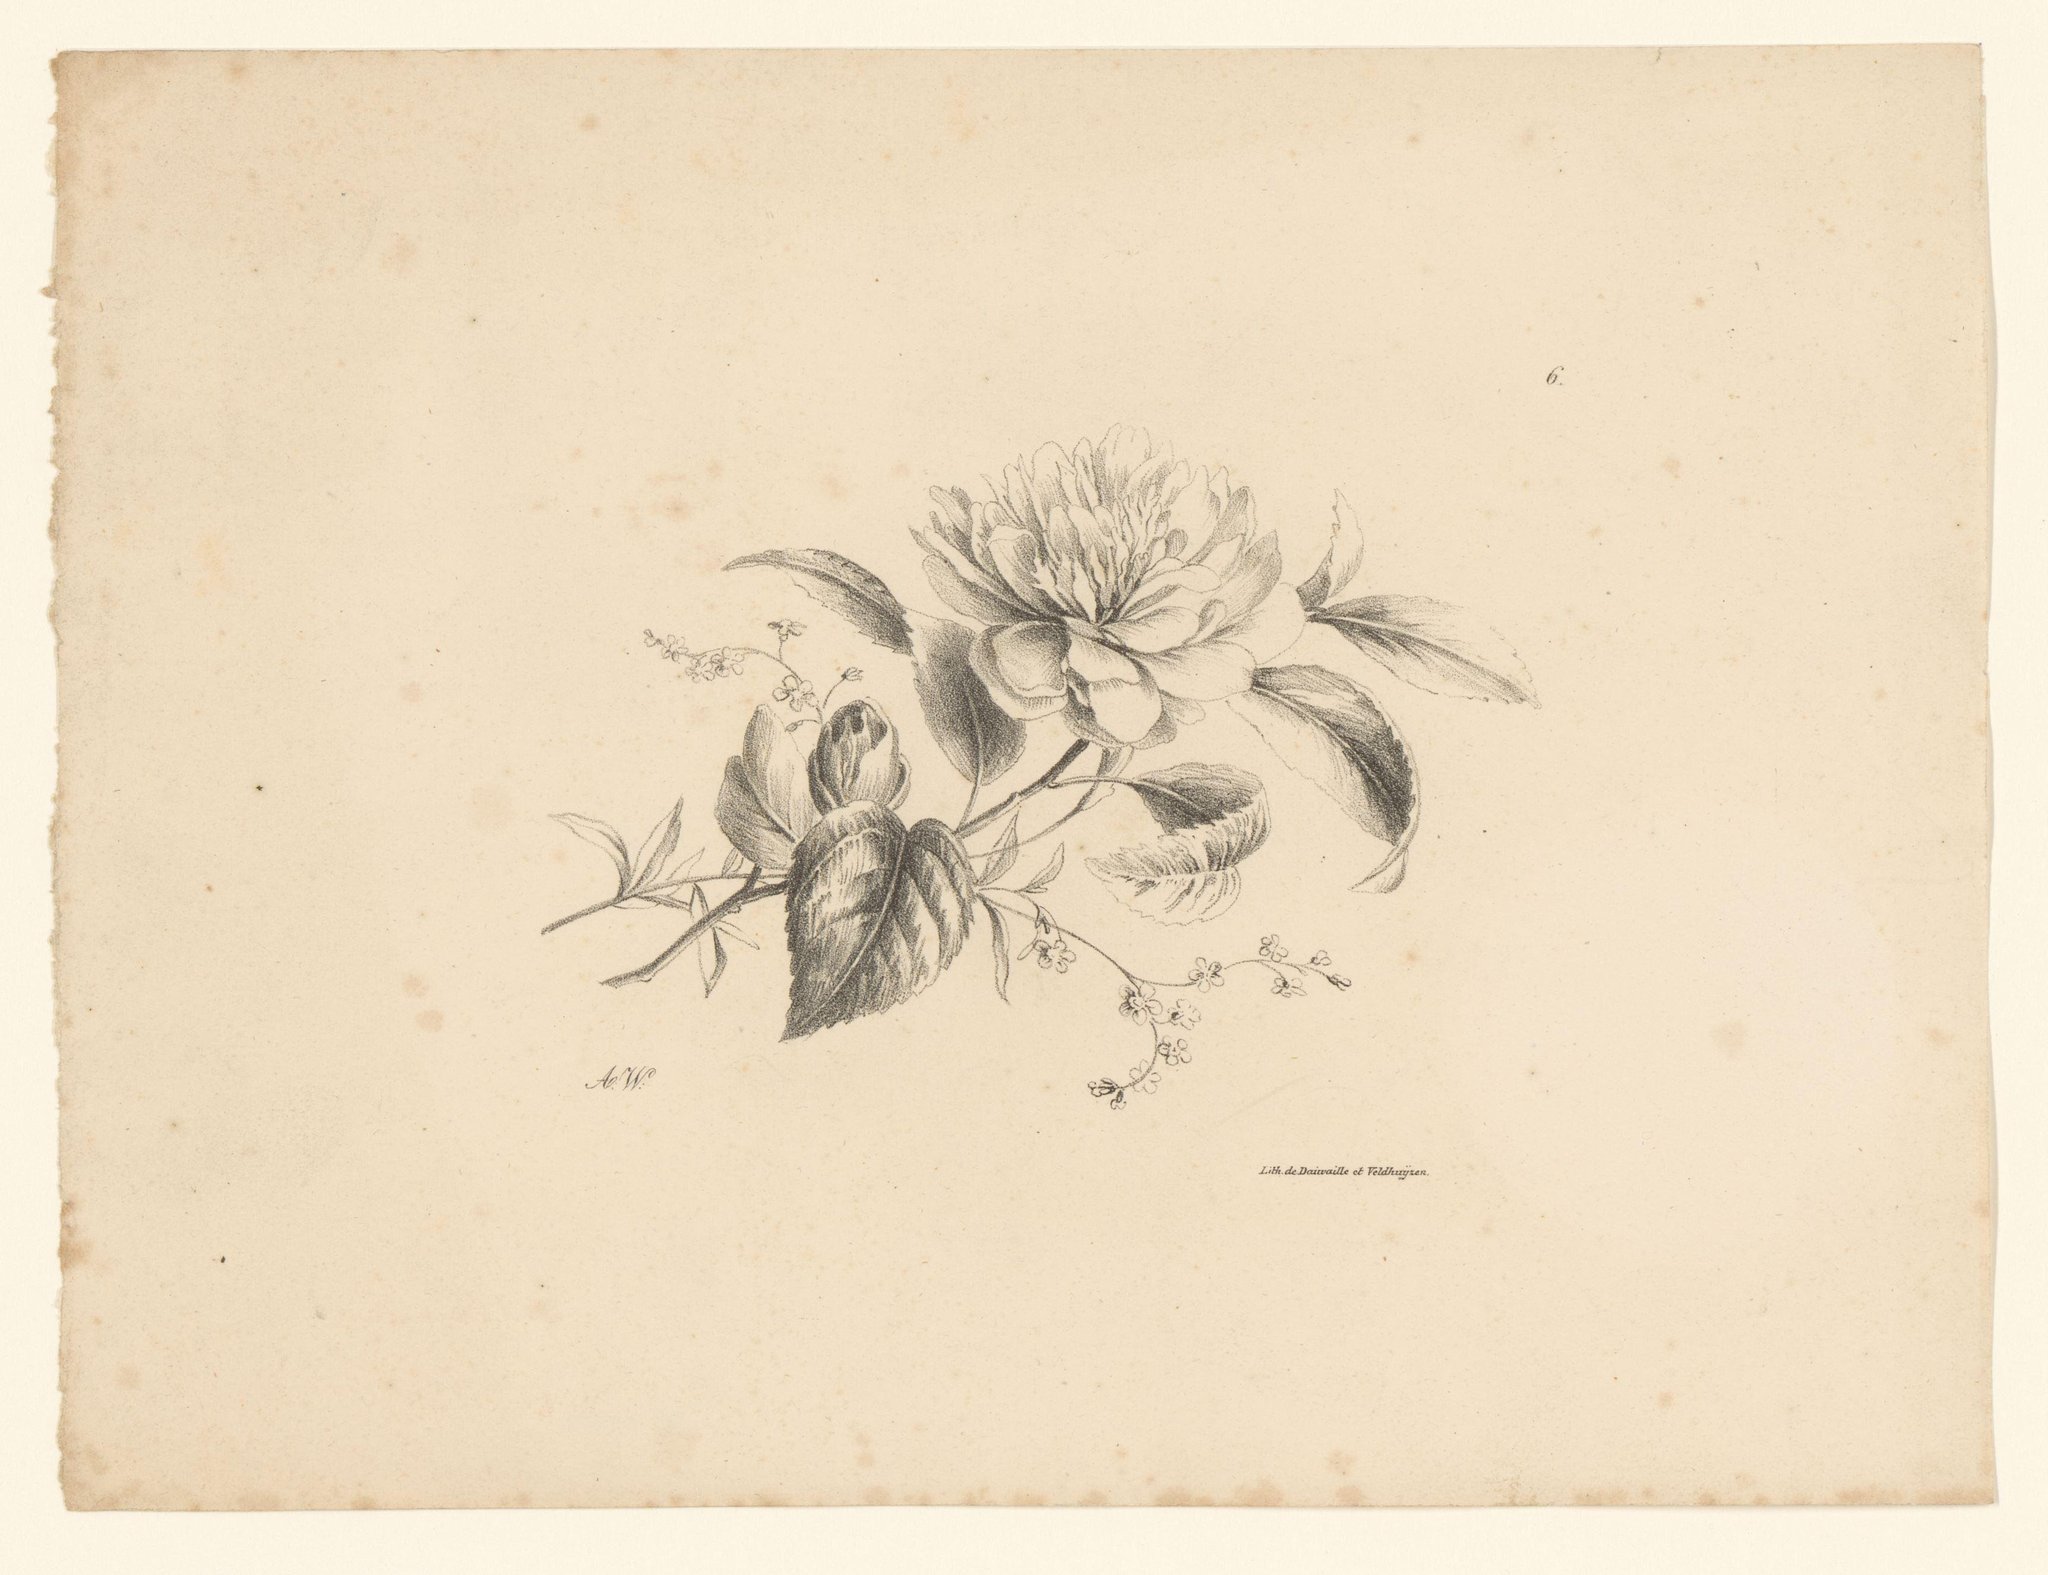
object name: print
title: Diverse bloemen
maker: anton weiss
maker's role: draughtsman, print maker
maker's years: 1801-1851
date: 1831-1832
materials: paper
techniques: lithograph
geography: netherlands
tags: flowers